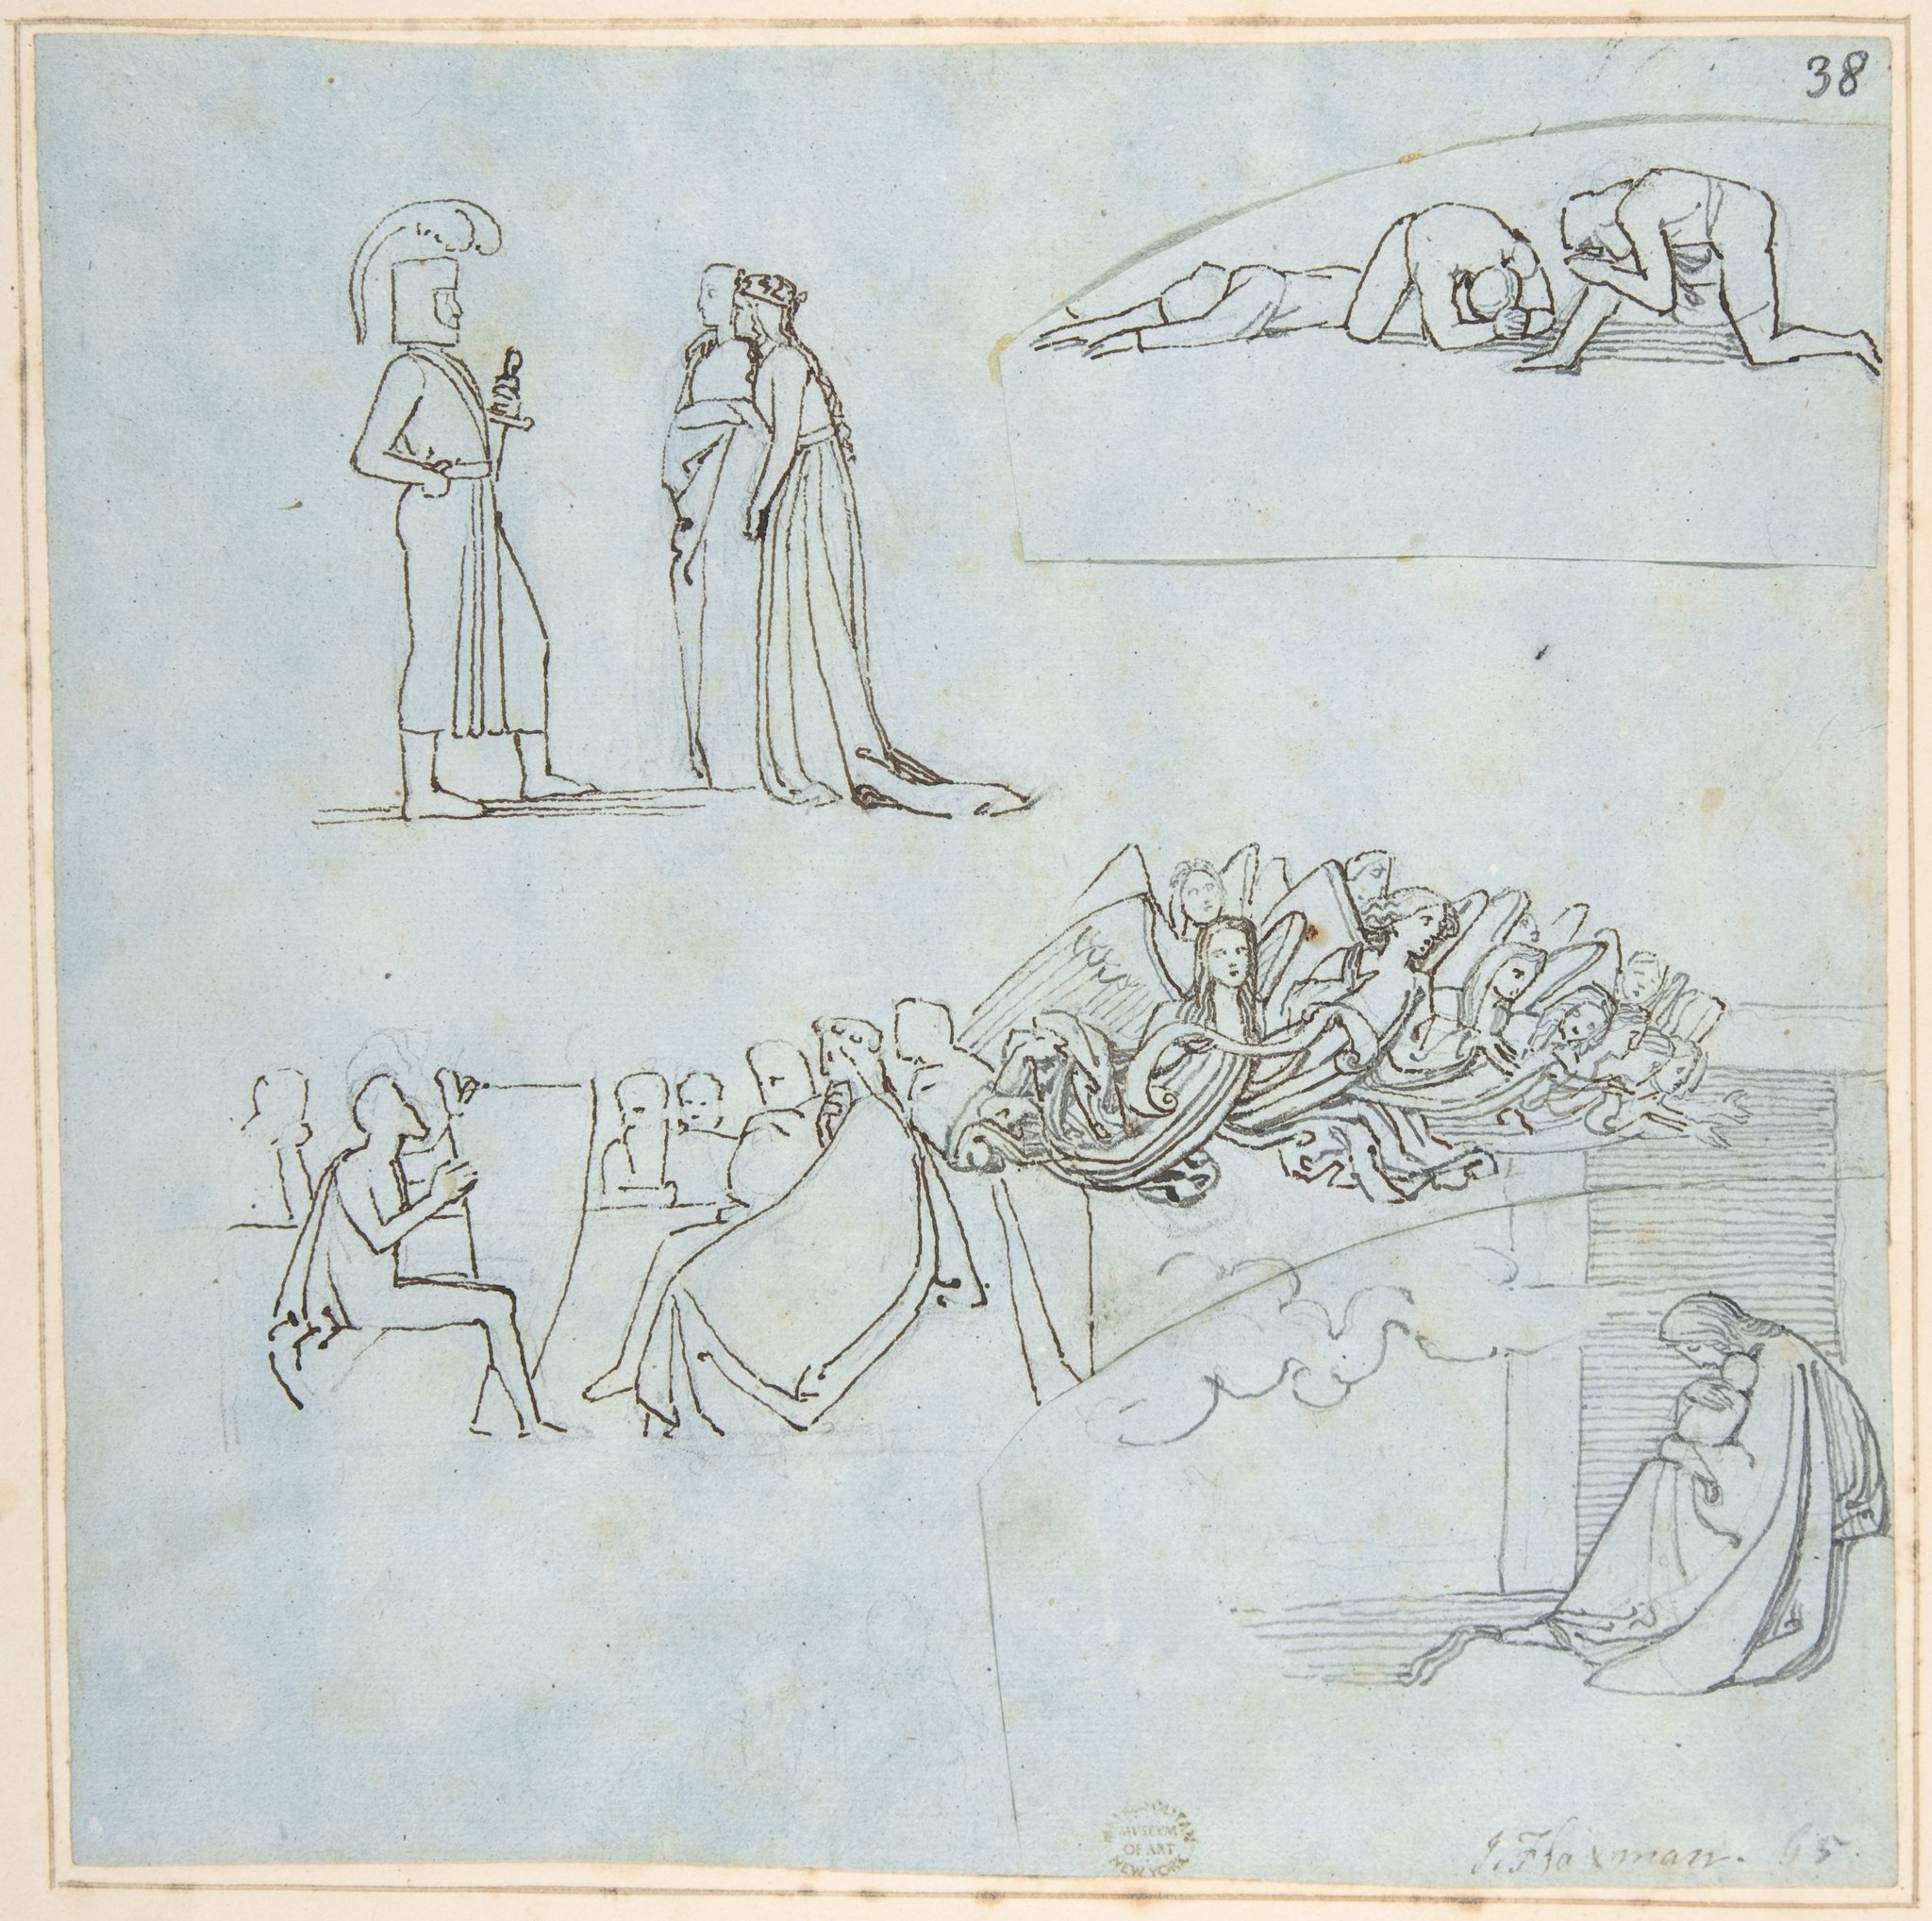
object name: drawing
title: Sheet of Sketches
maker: john flaxman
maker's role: artist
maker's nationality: british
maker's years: 1755-1826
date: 1793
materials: graphite, ink, paper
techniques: pen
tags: men,women